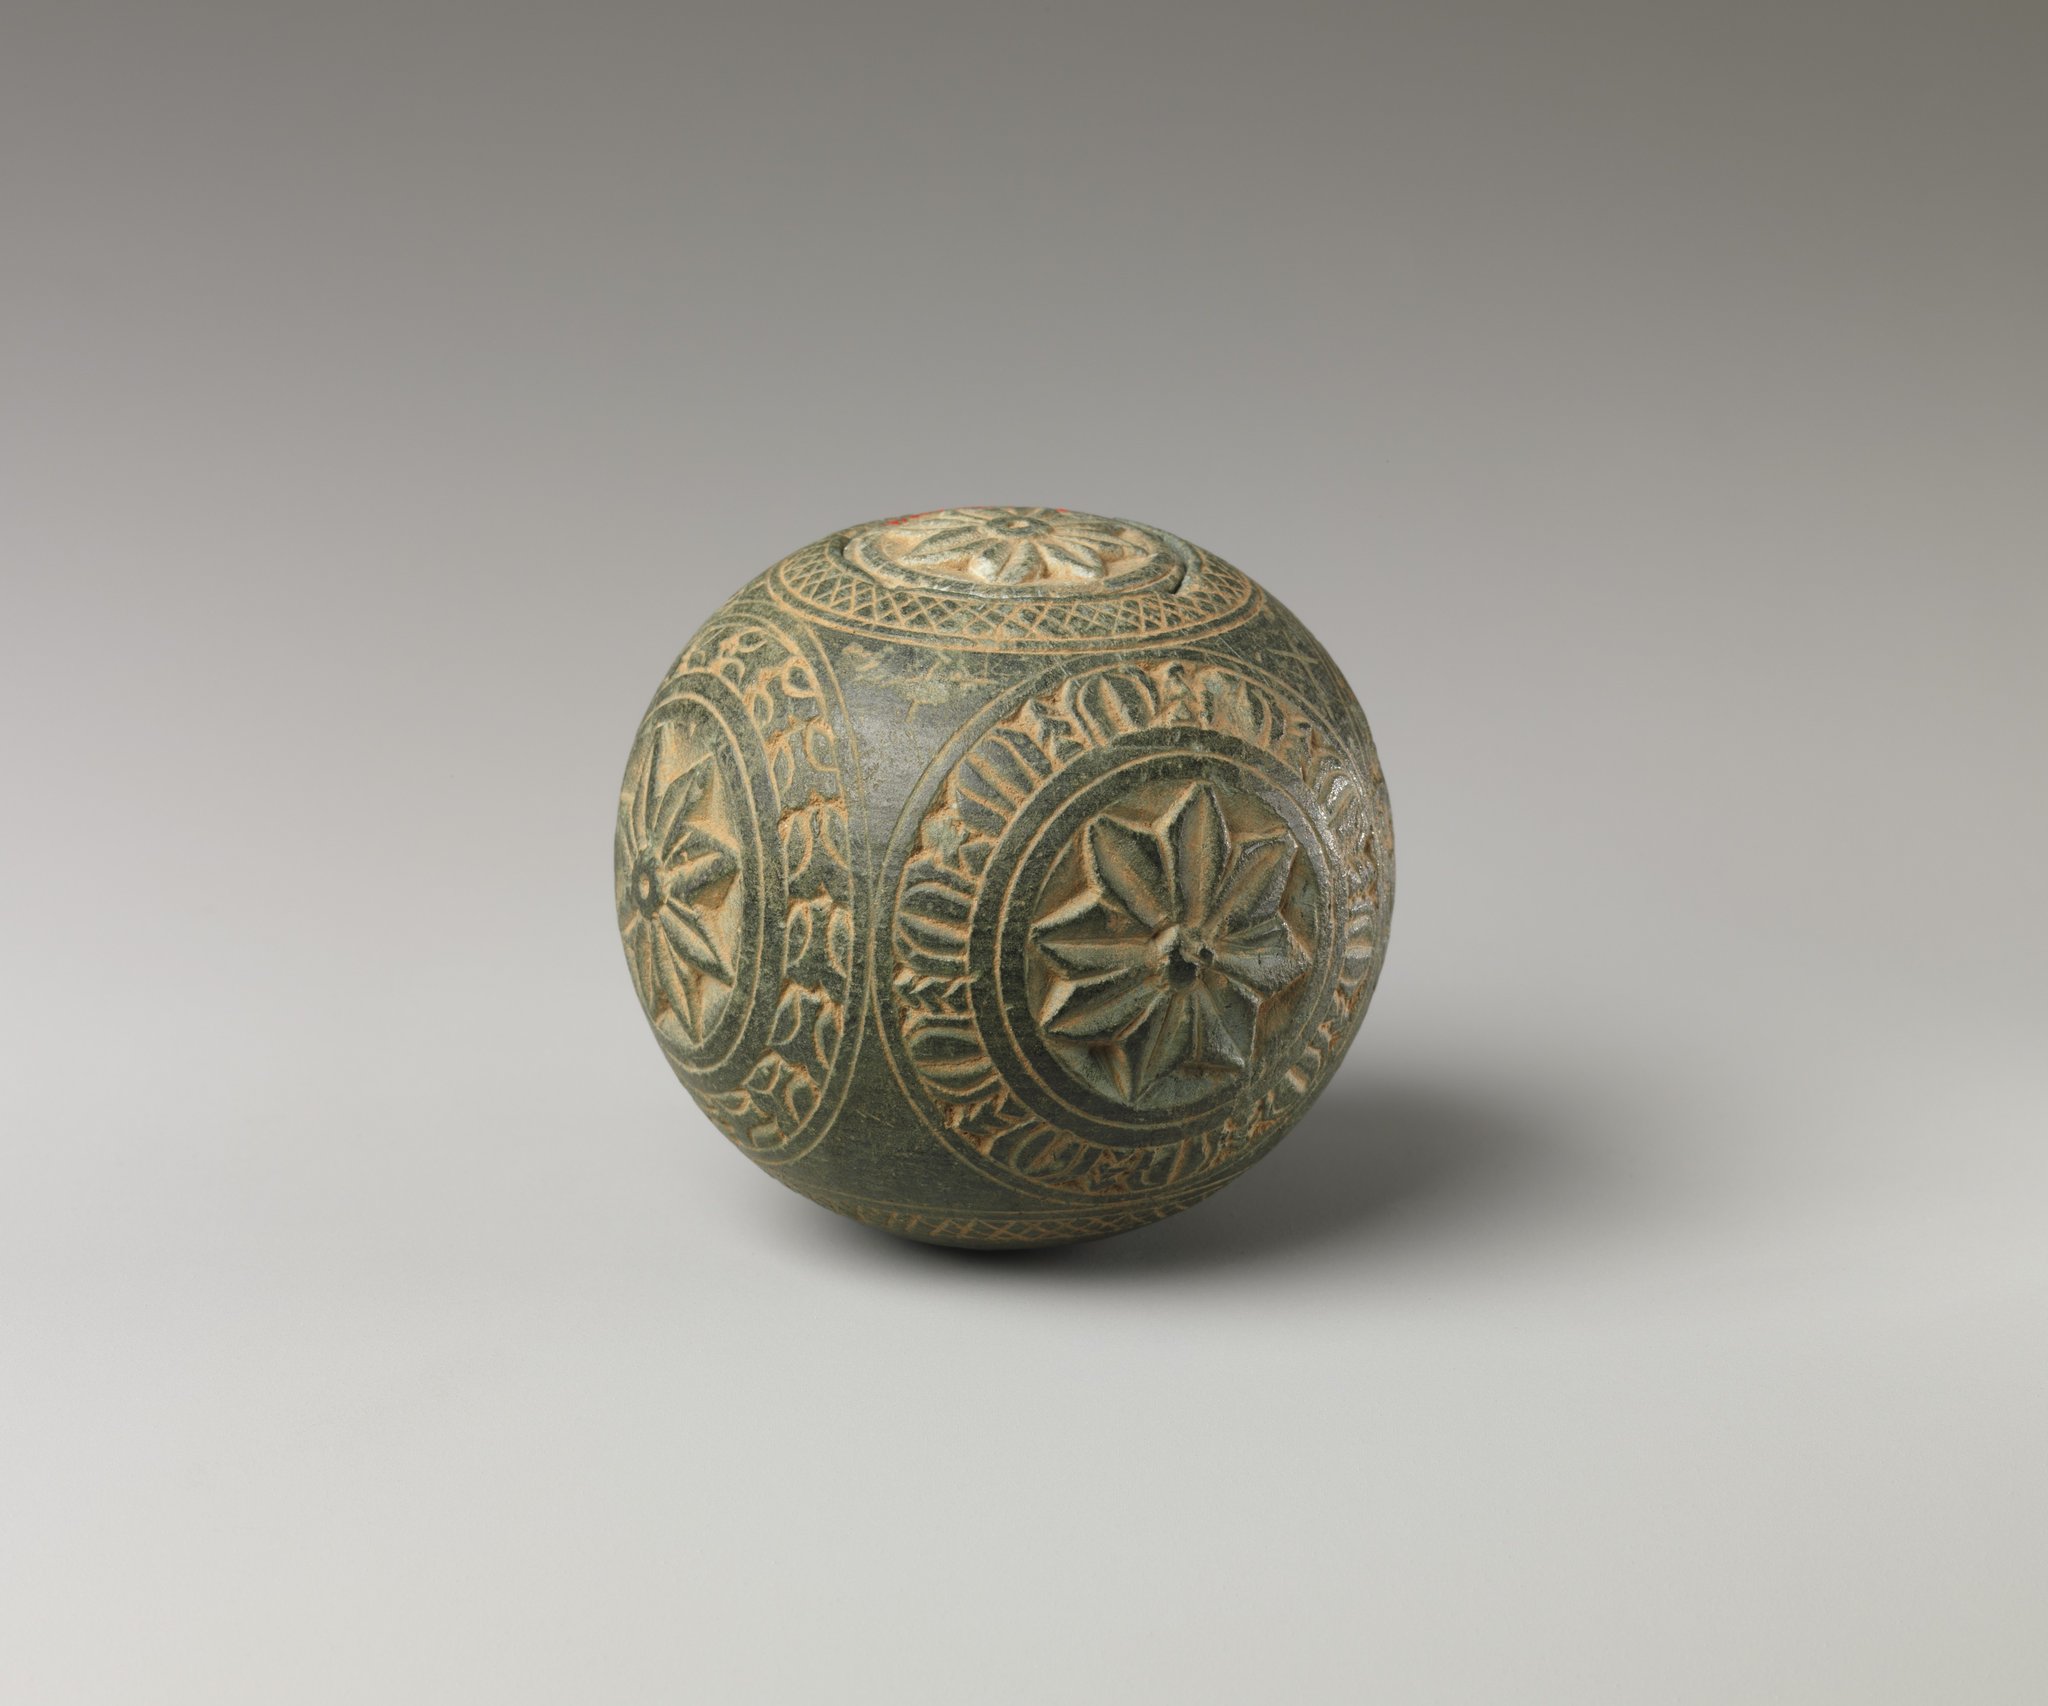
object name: reliquary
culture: gandhara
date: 1-300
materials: stone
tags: gandhara